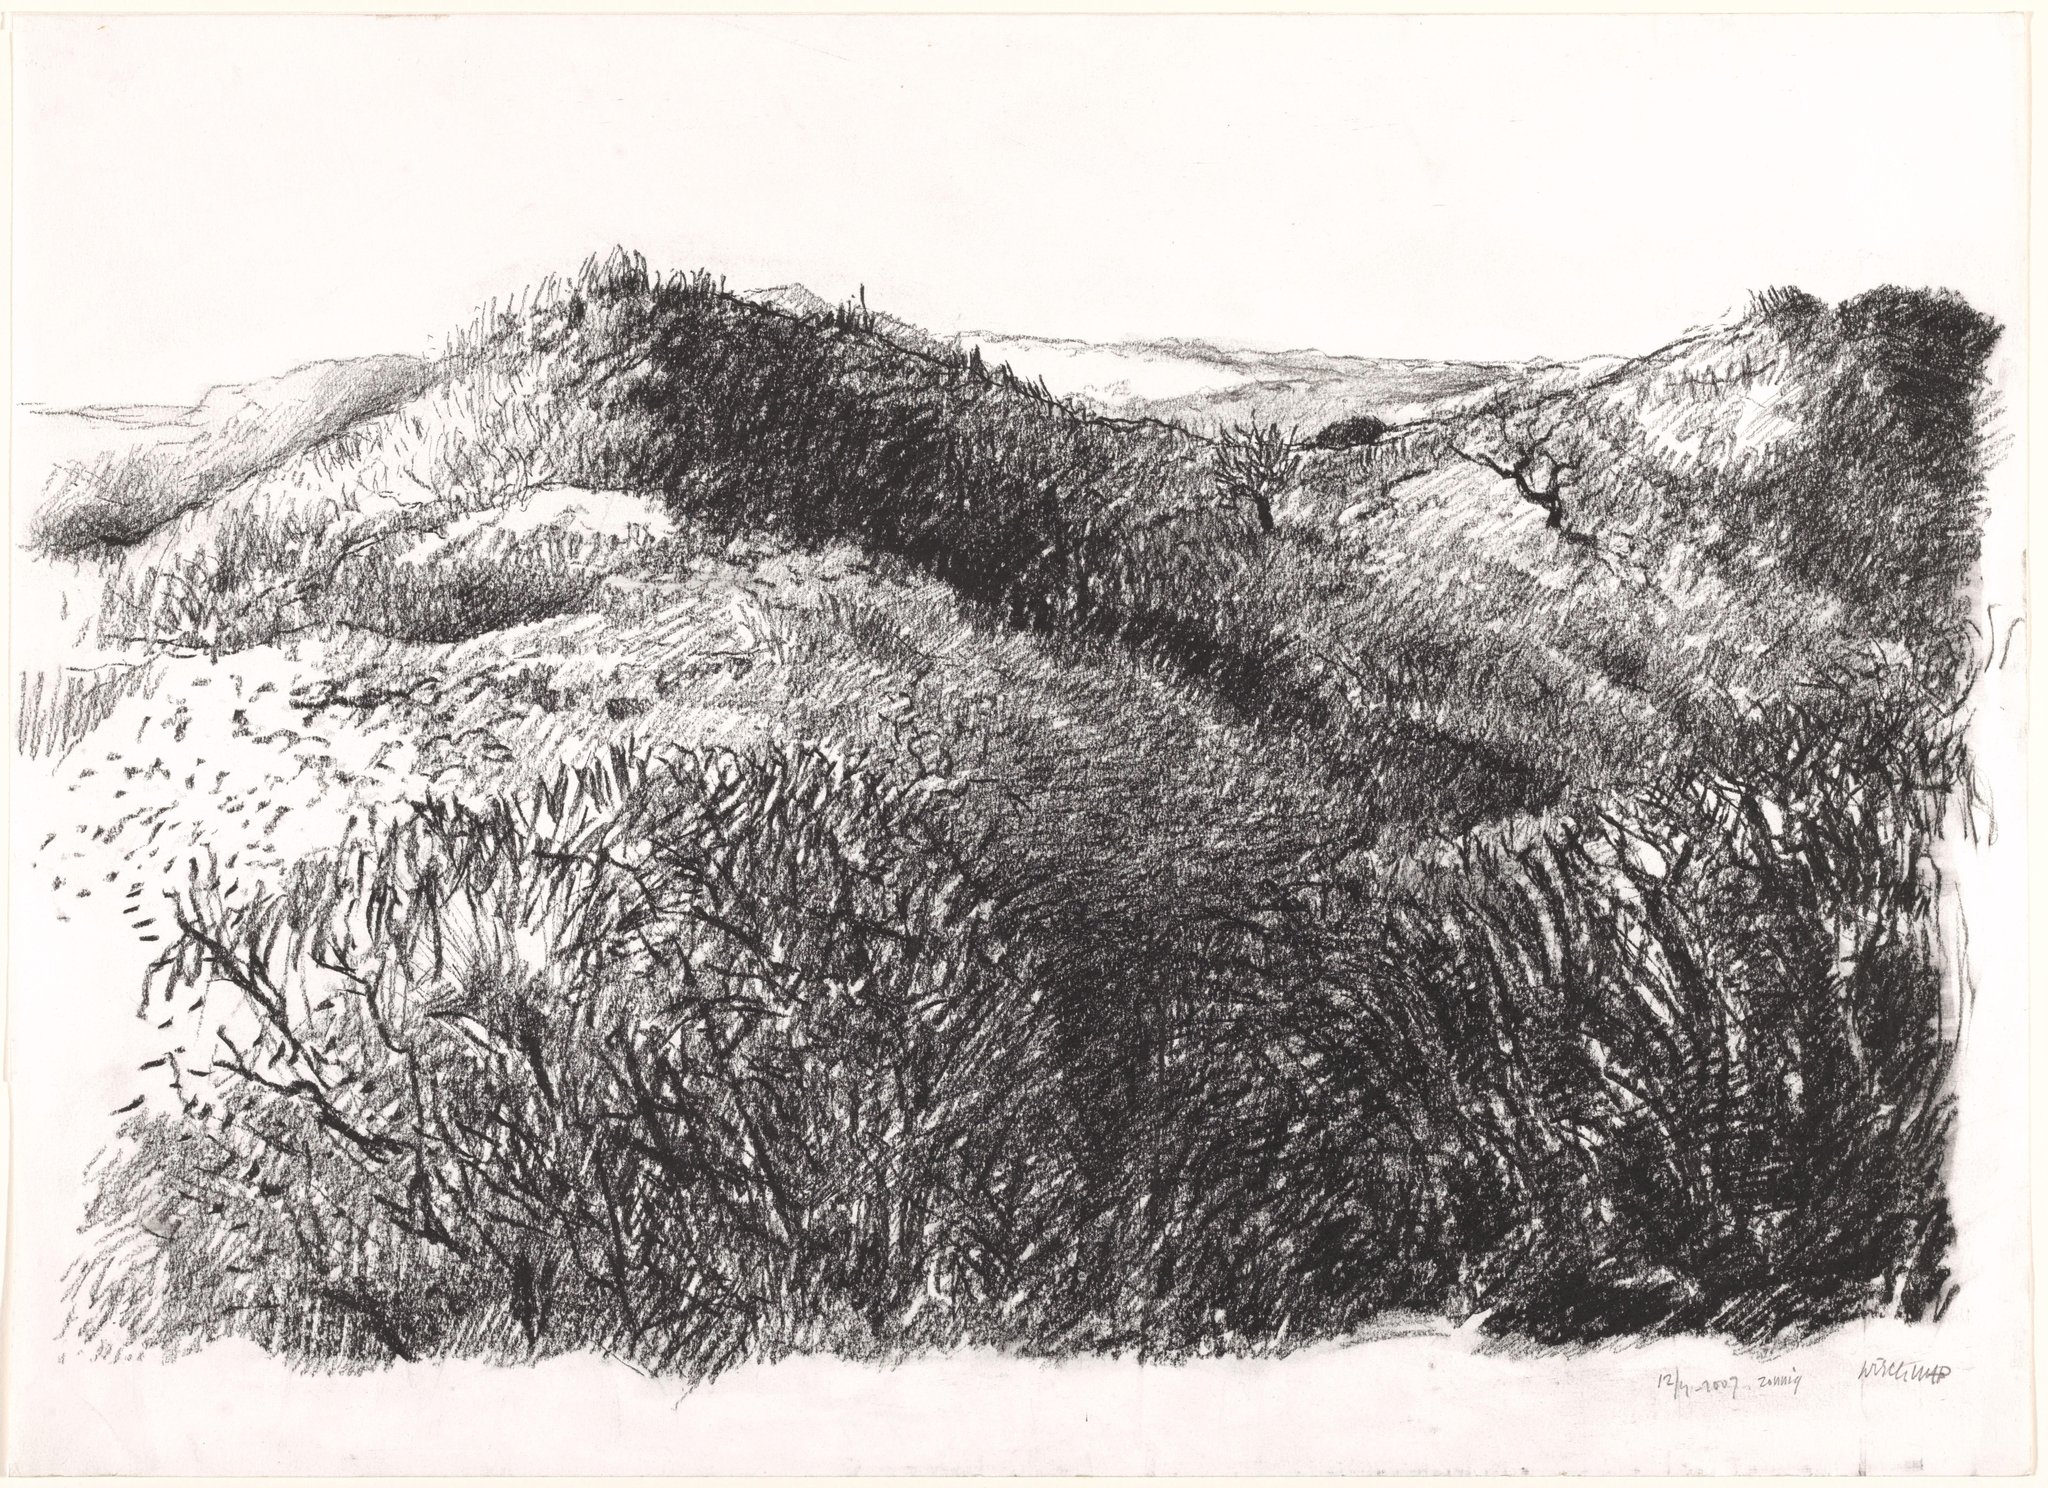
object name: drawing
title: 'Zonnig' duinlandschap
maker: dirck nab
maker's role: draughtsman, painter, print maker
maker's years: 1940-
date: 2007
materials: chalk, paper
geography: bakkum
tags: dunes (sea not visible); in the dunes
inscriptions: signature, date and inscription: ‘12/7-2007 zonnig Dirck Nab’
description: Gezicht op twee belichte duintoppen, op de voorgrond stekelige begroeiing.